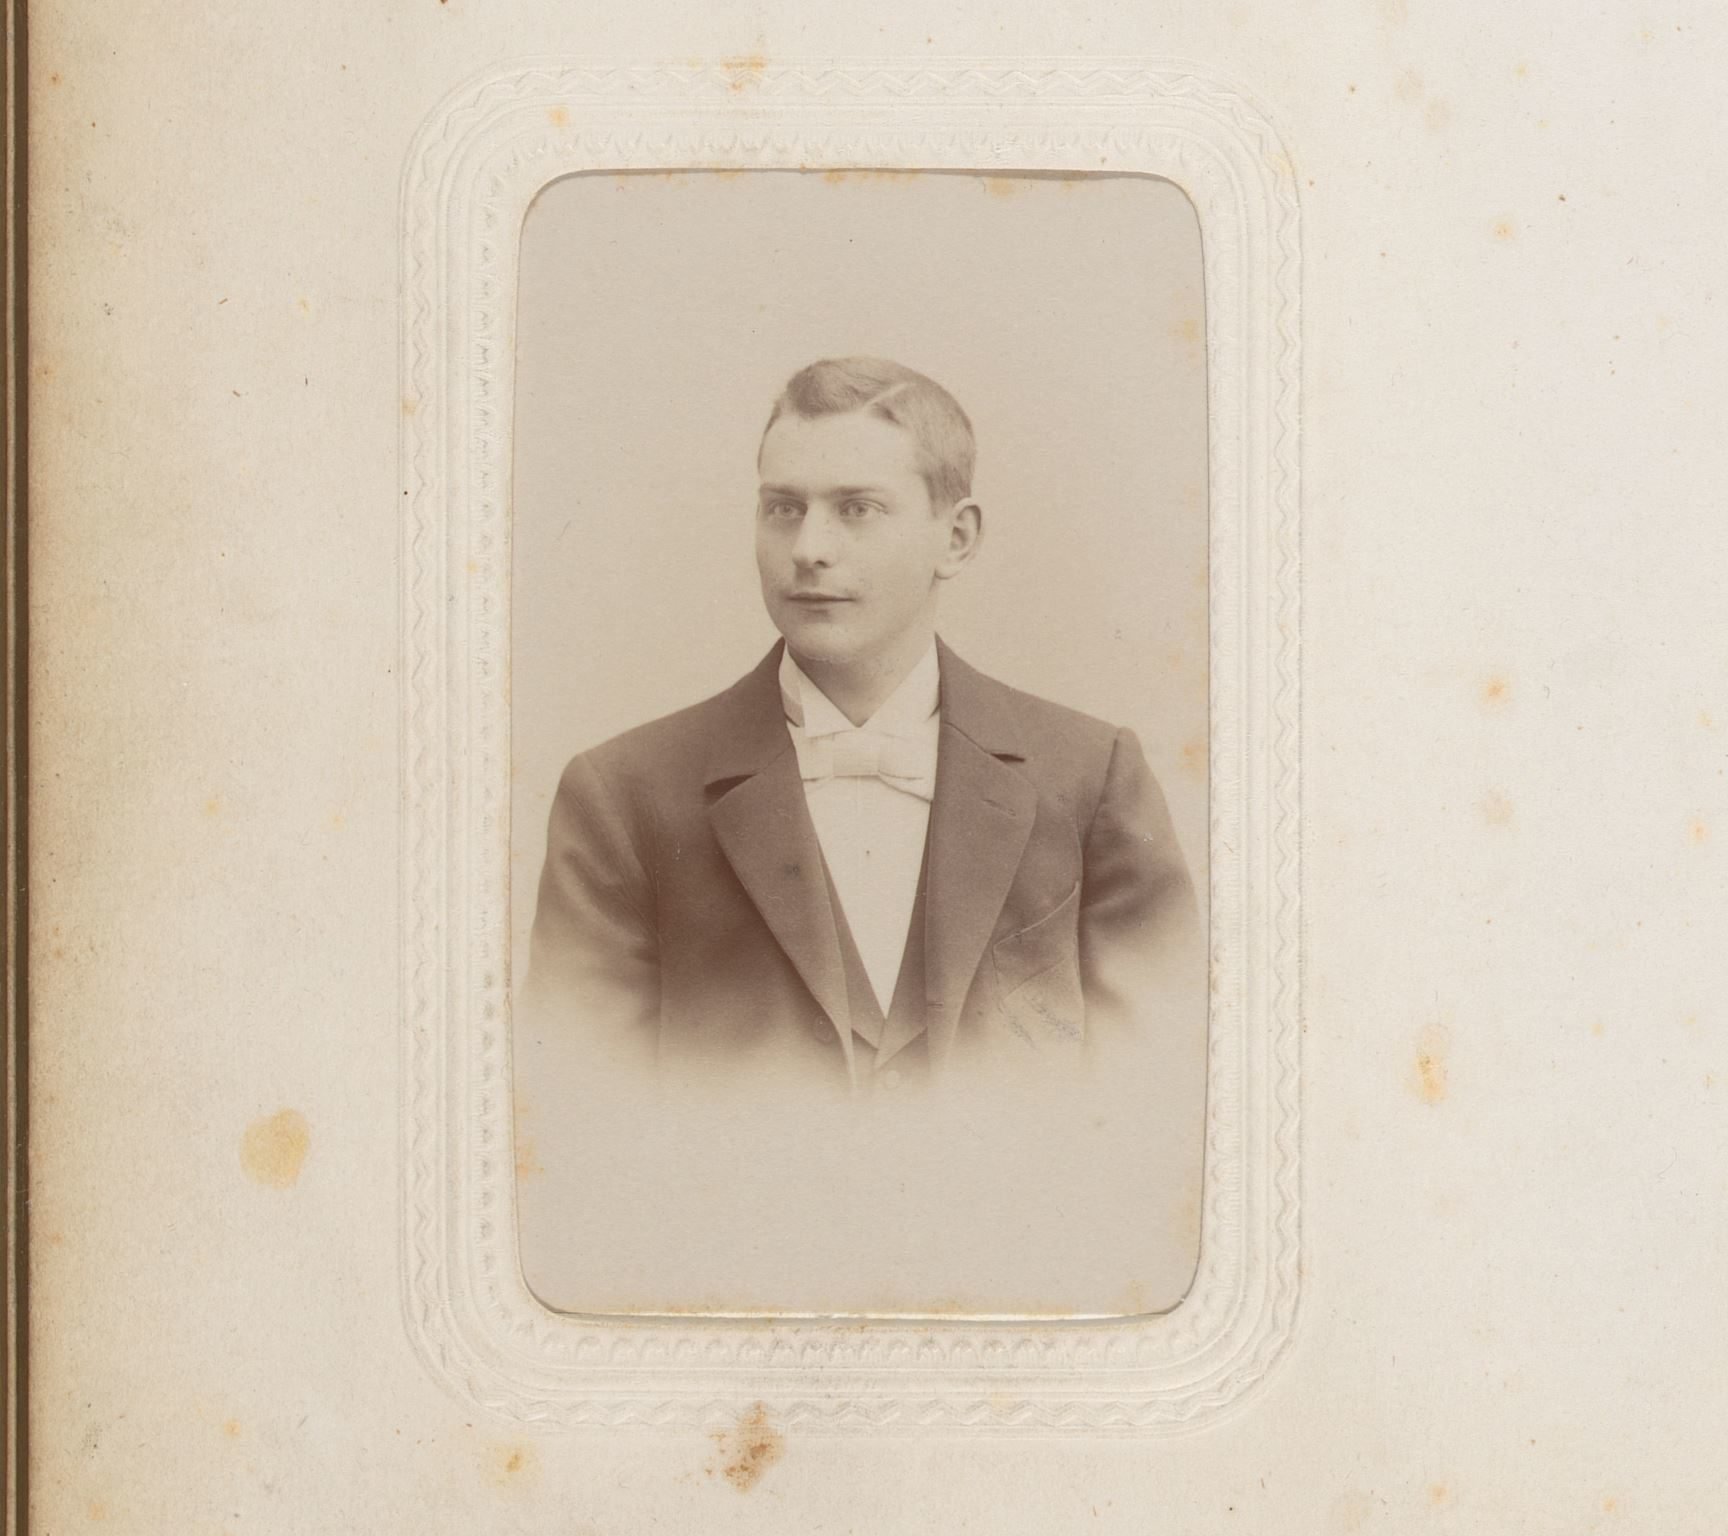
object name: photograph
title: Portret van een jonge man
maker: Anonymous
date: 1850-1900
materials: cardboard, photographic support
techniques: albumen print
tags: historical persons, youth, adolescent